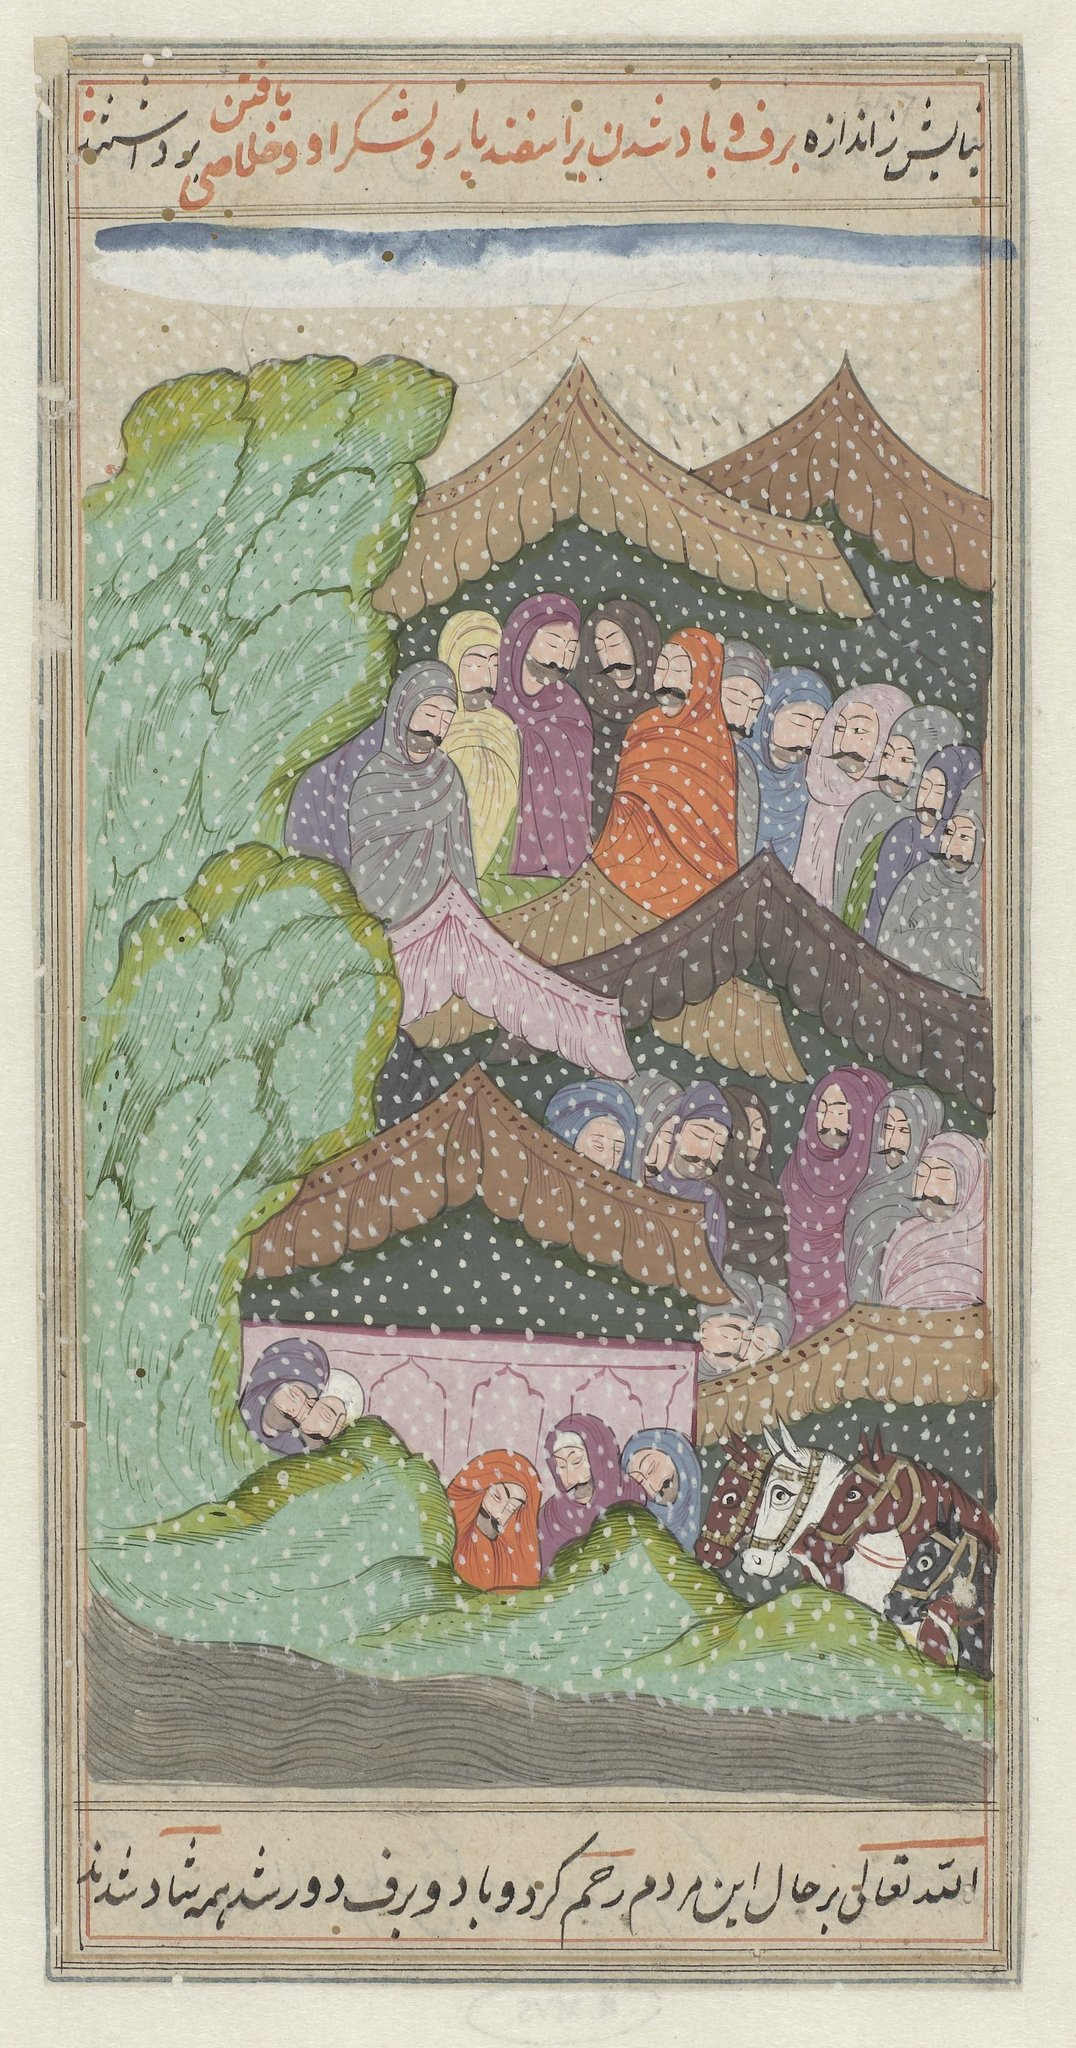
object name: indian miniature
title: Isfandiyar met leger in sneeuwstorm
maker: Anonymous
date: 1790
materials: paper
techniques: brush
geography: deccan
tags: snowstorm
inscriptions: inscription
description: Achter een patroon van groene heuveltjes en bomen met tenten als achtergrond is een processie van drie verticale rijen halve figuren zichtbaar, op de onderste rij gevolgd door een viertal paardenkoppen. Het geheel is besprenkeld met witte stipjes die de sneeuw voorstellen. De lange smalle voorstelling is gevat in kaderlijnen in zwart, lichtbruin en rood.